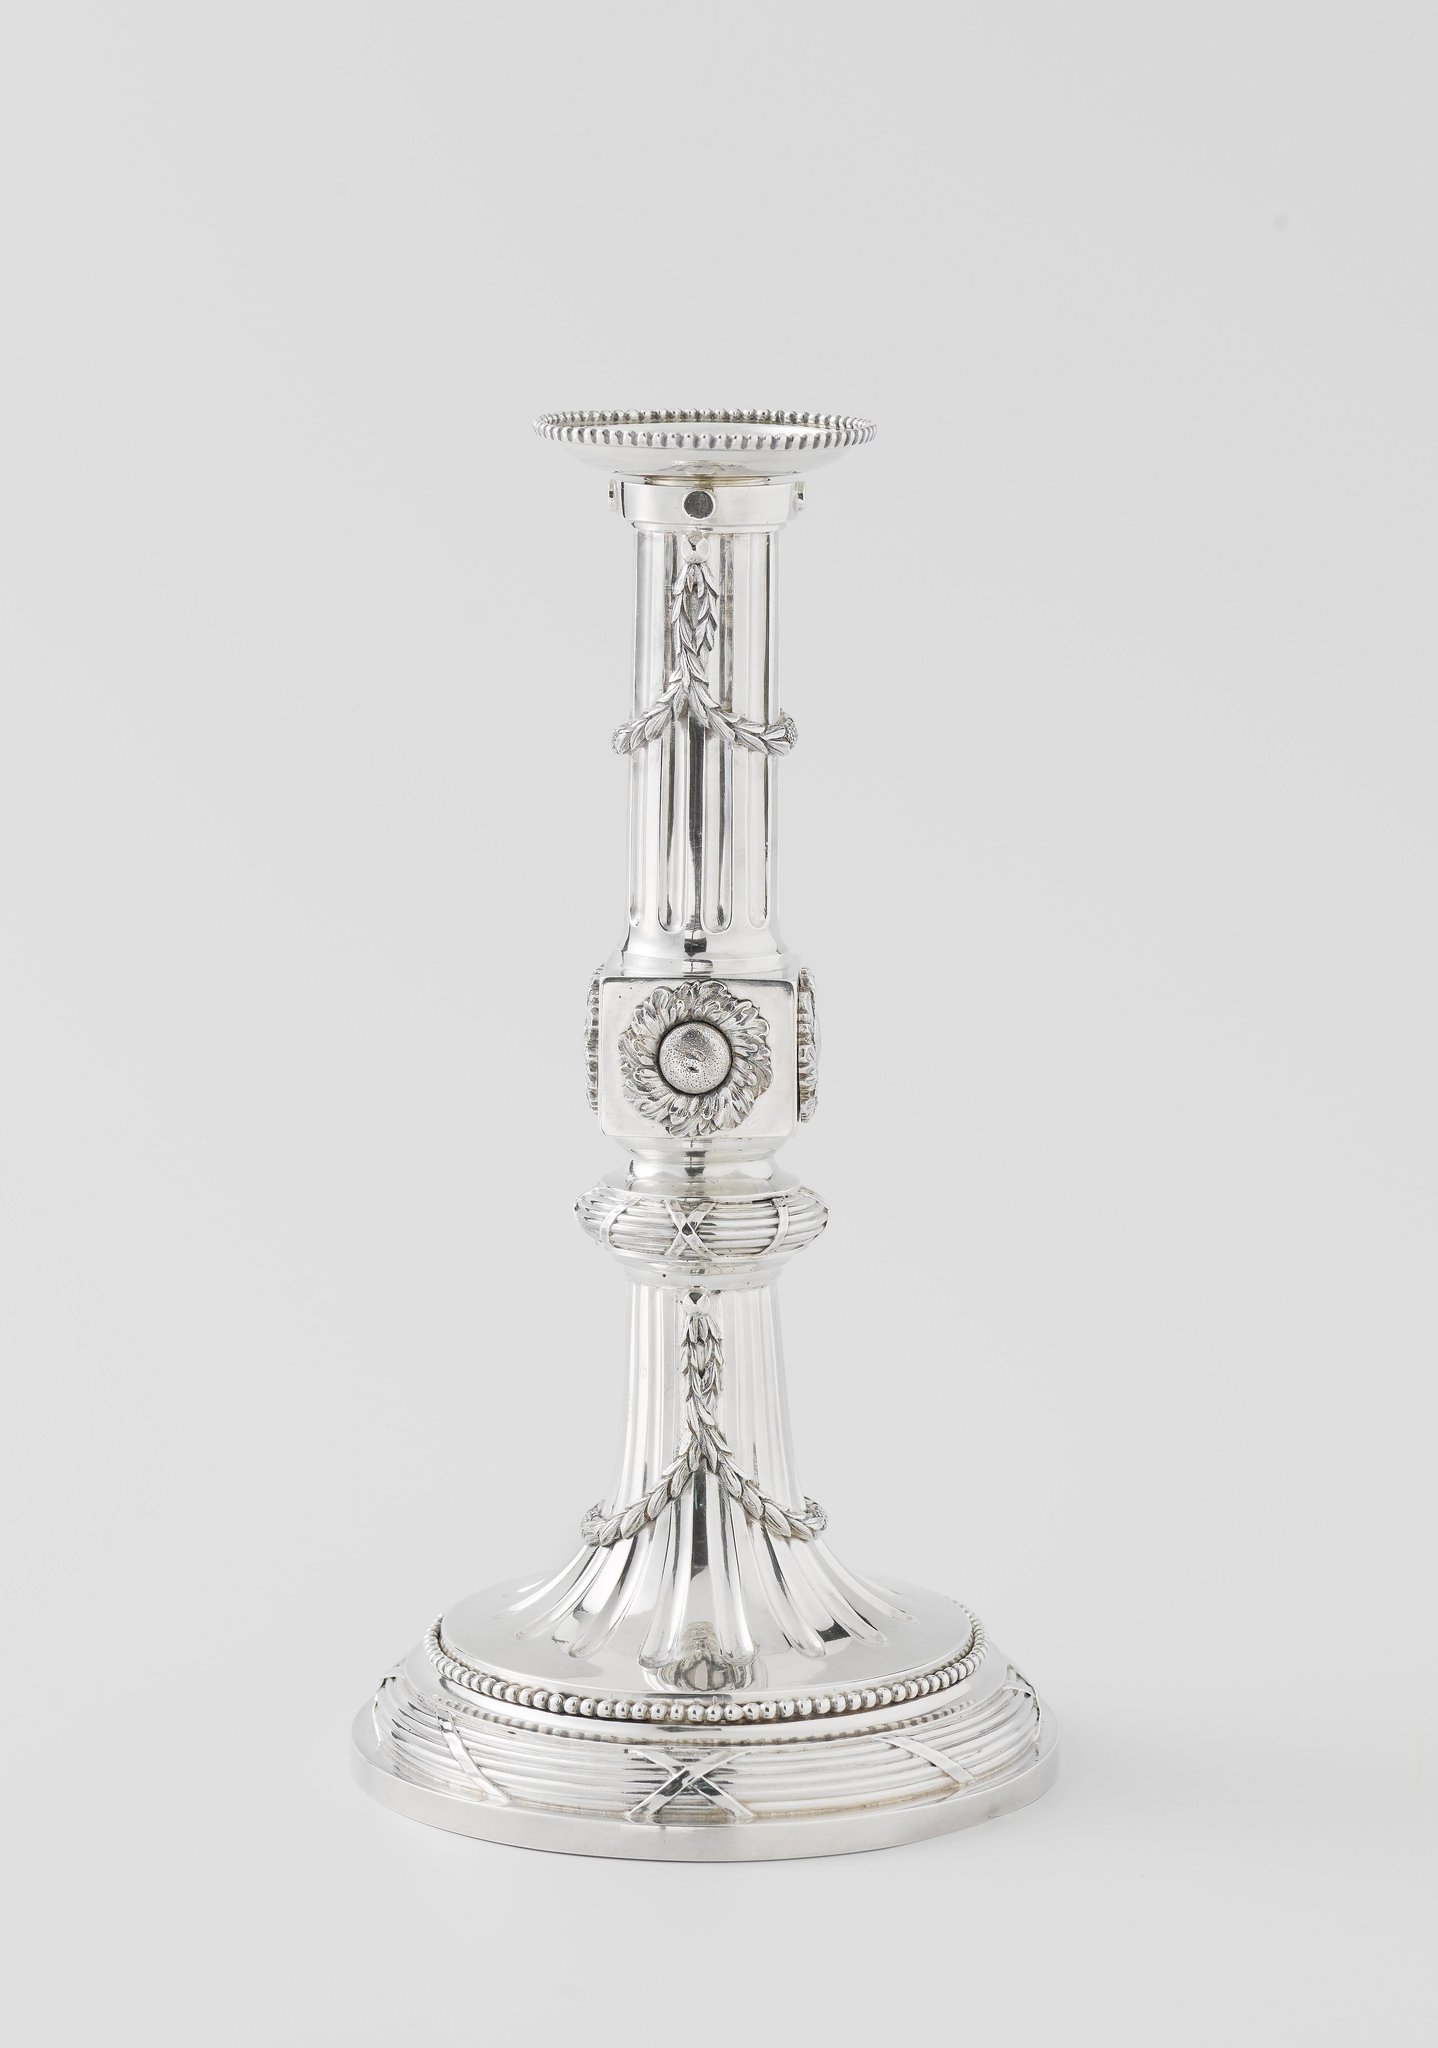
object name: candlestick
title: Four candlesticks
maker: cornelis hendrik bömcke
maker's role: silversmith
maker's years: 1758-1818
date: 1783-1784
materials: silver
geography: amsterdam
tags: ornaments ~ art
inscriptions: maker's mark, town mark, alloy mark, date letter: ‘Z’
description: The design of these candlesticks, with a cubic knob with rosettes in the middle of the stem, is derived from Parisian models. Similar candlesticks were made in various European centres, but the quality of these Amsterdam examples comes very close to that of the silver produced in Paris.